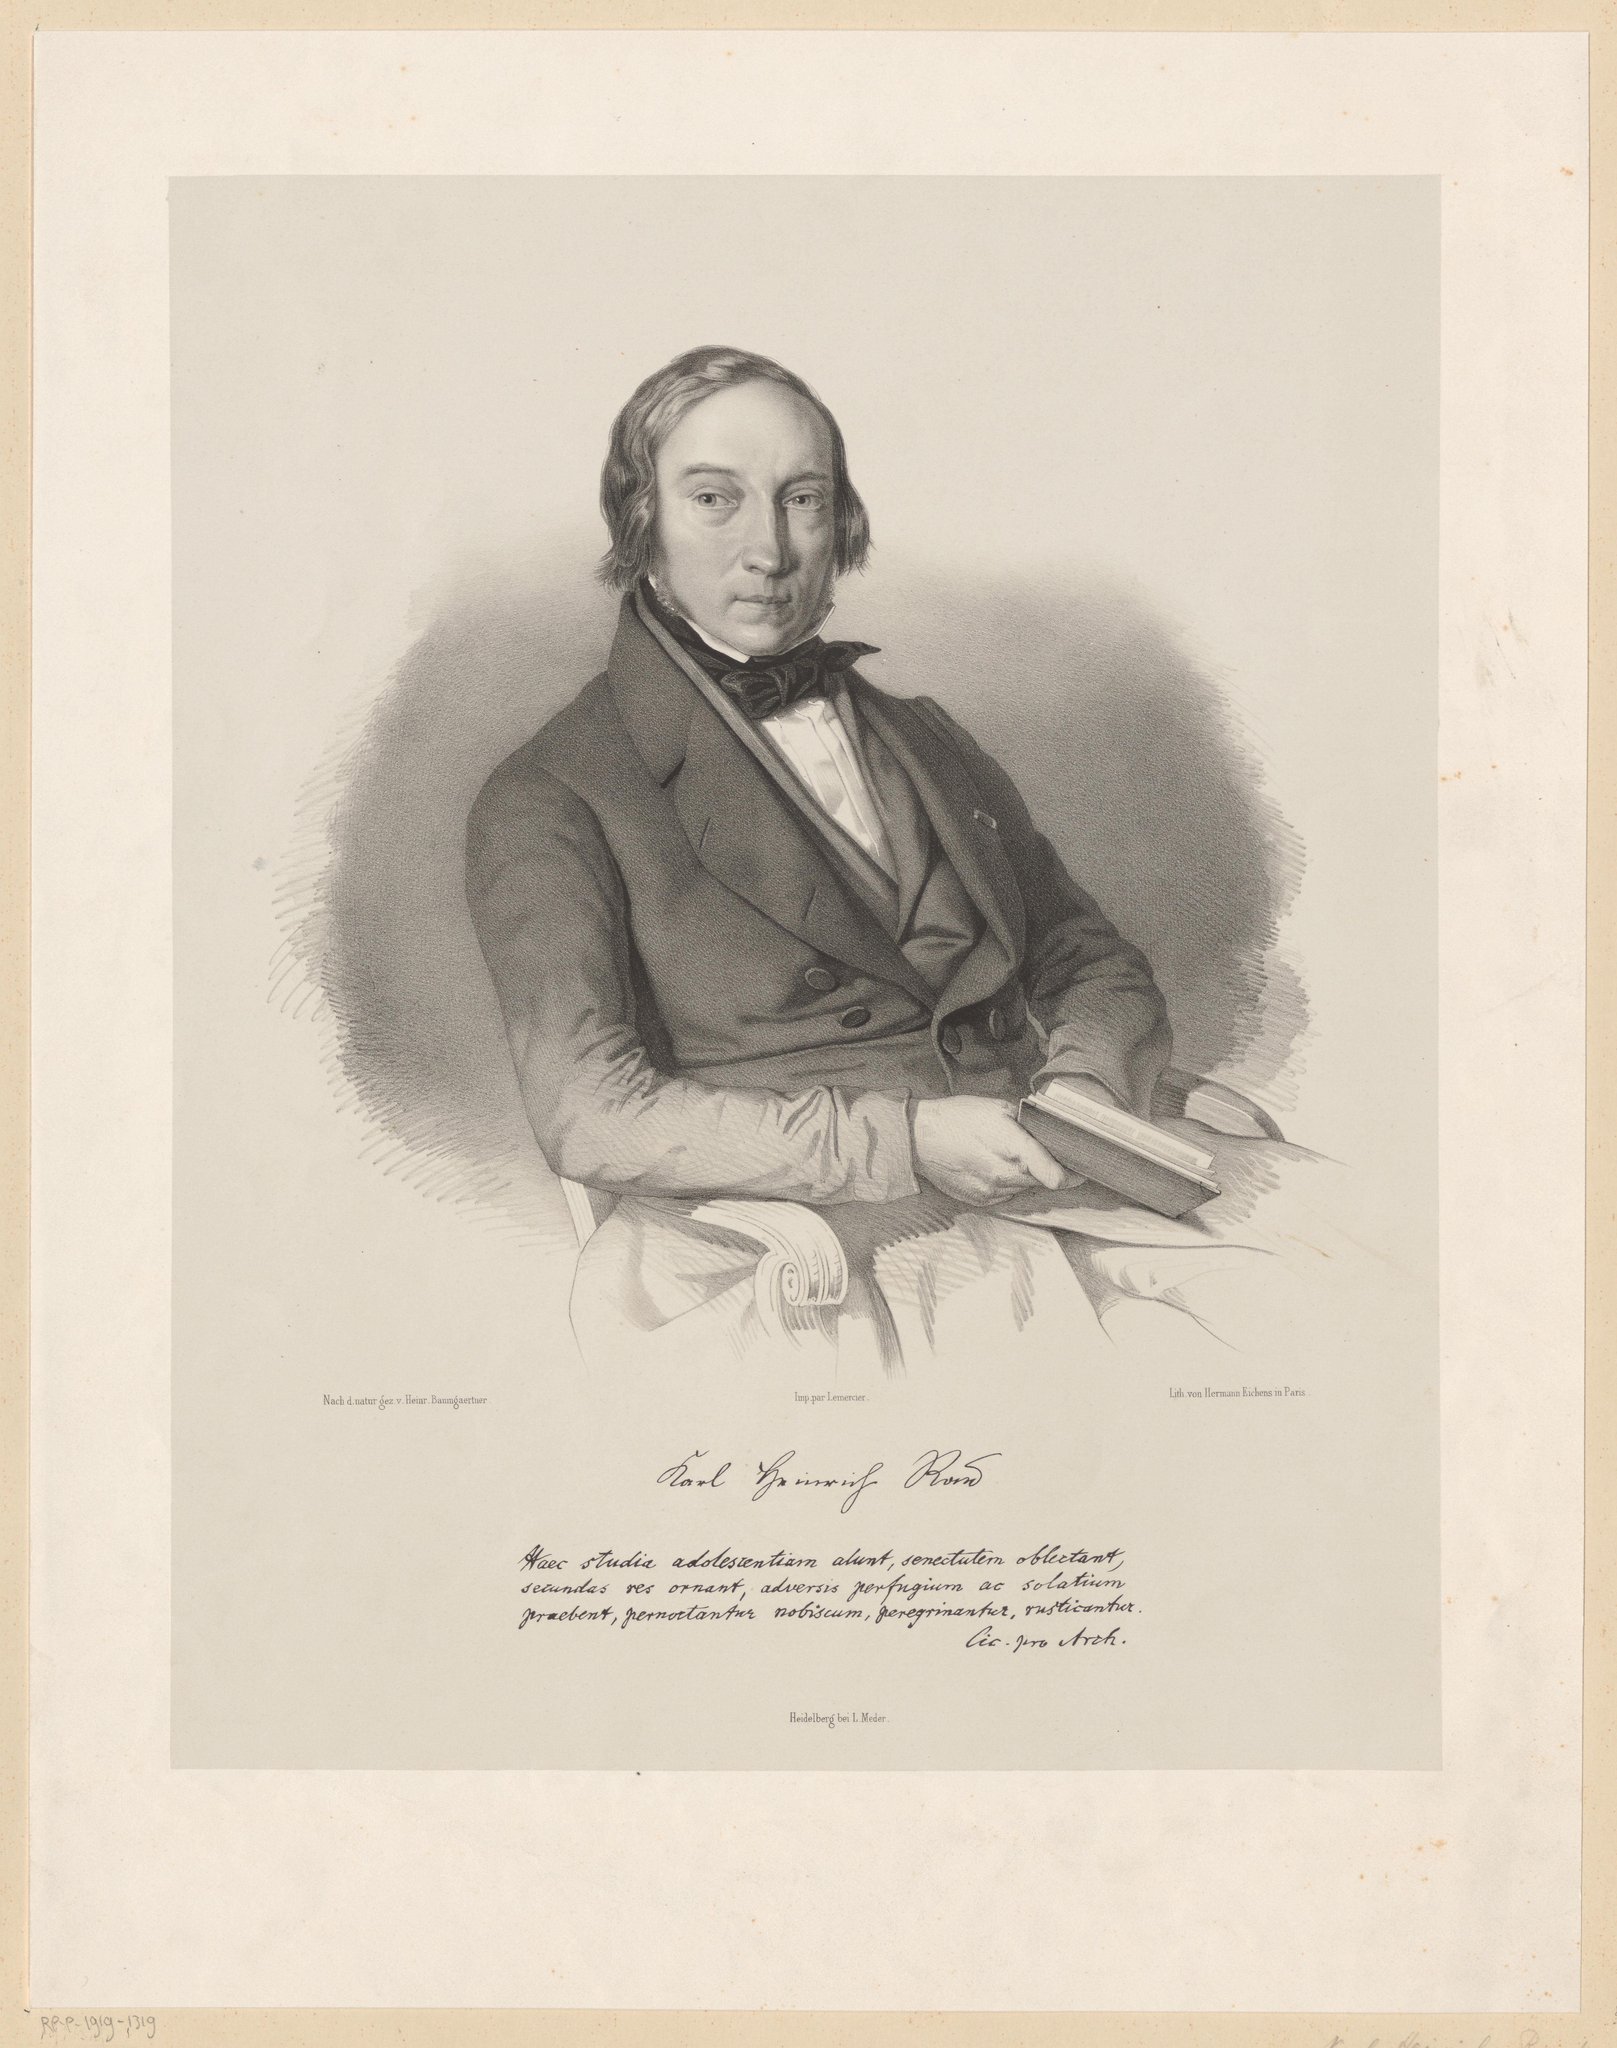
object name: print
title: Portret van Karl Heinrich Rau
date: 1858-1901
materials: paper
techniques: lithograph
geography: paris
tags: historical persons, book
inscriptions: collector's mark: Lugt 2228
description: Onder het portret een facsimile van de handtekening van de geportretteerde.